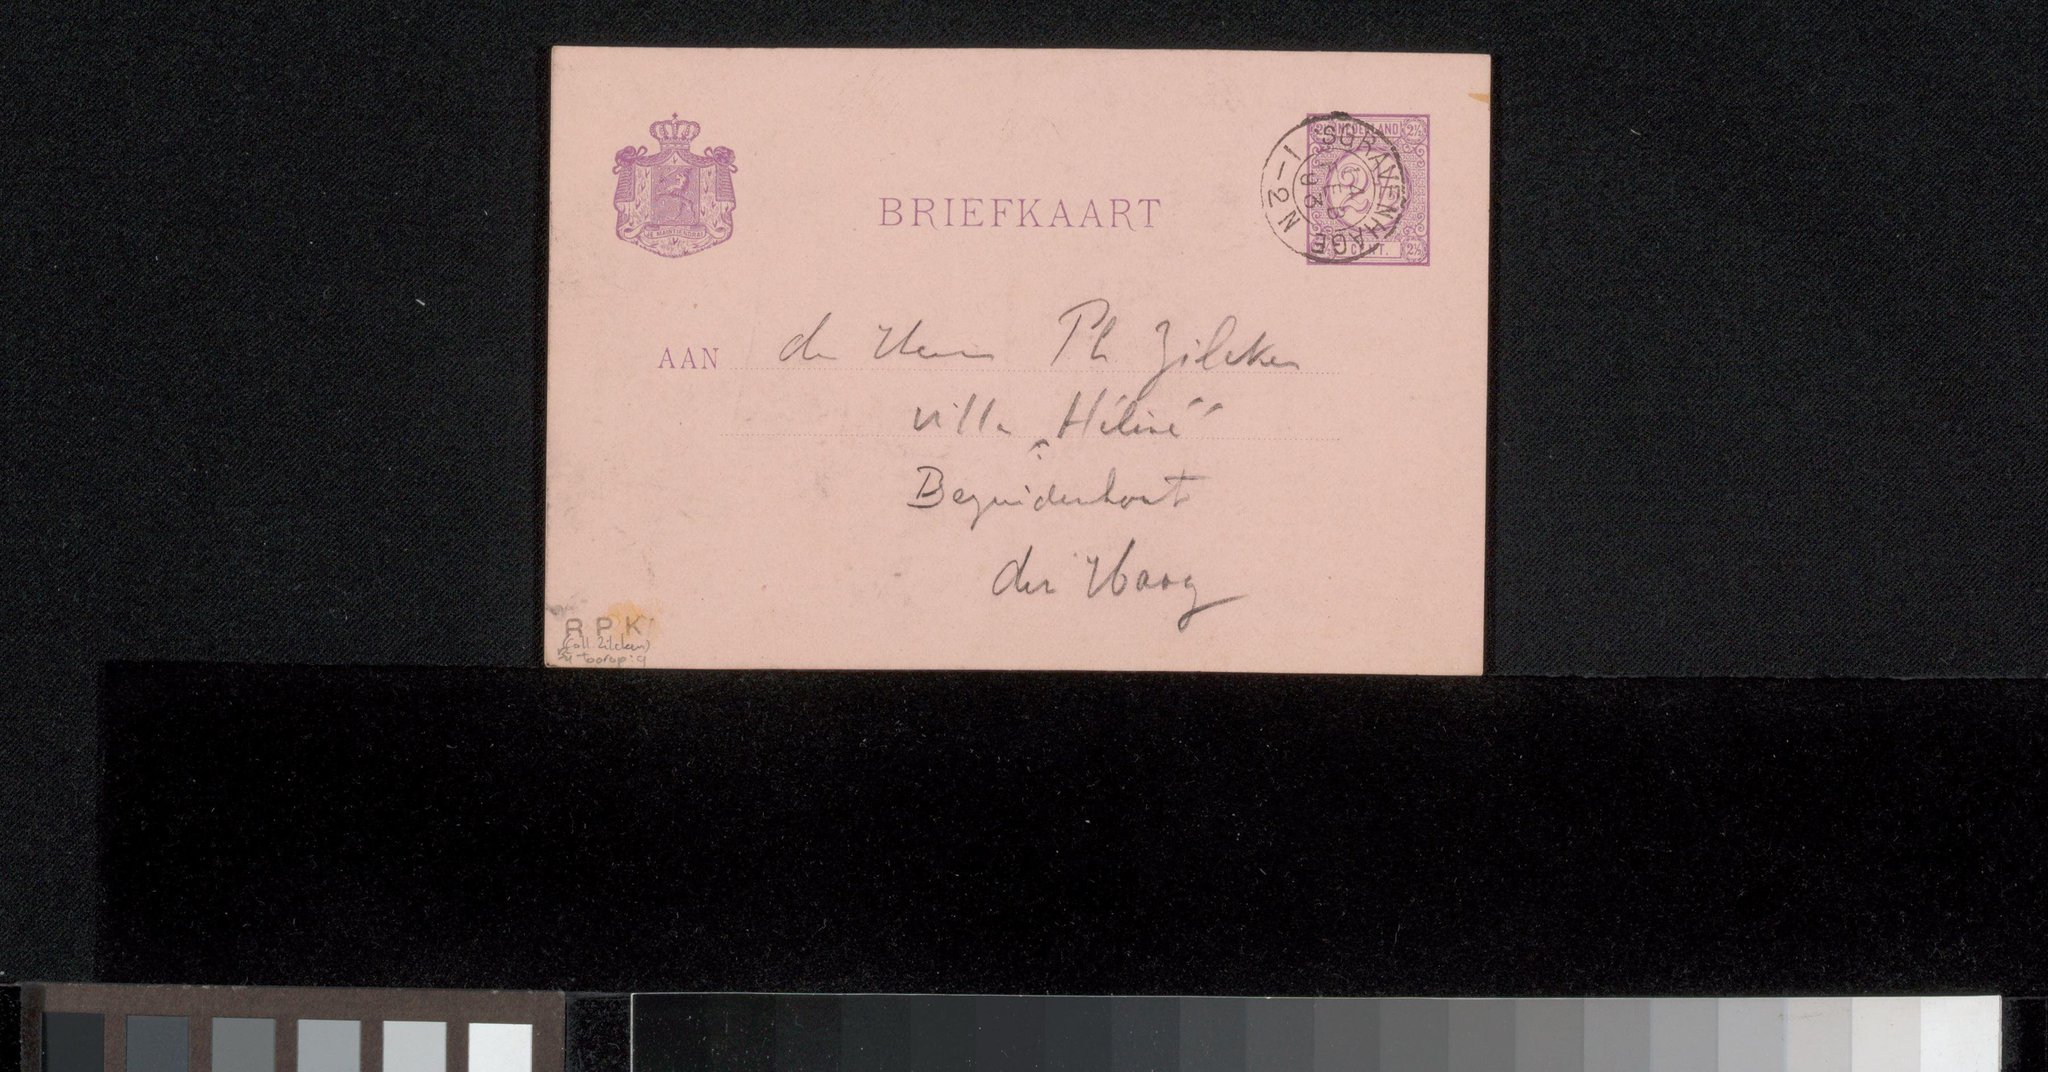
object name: postcard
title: Briefkaart aan Philip Zilcken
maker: jan toorop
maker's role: draughtsman, painter, print maker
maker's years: 1858-1928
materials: cardboard, pencil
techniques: writing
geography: the hague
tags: arij prins, philip zilcken, exhibition ~ art, printed matter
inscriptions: collector's mark: ‘RPK’